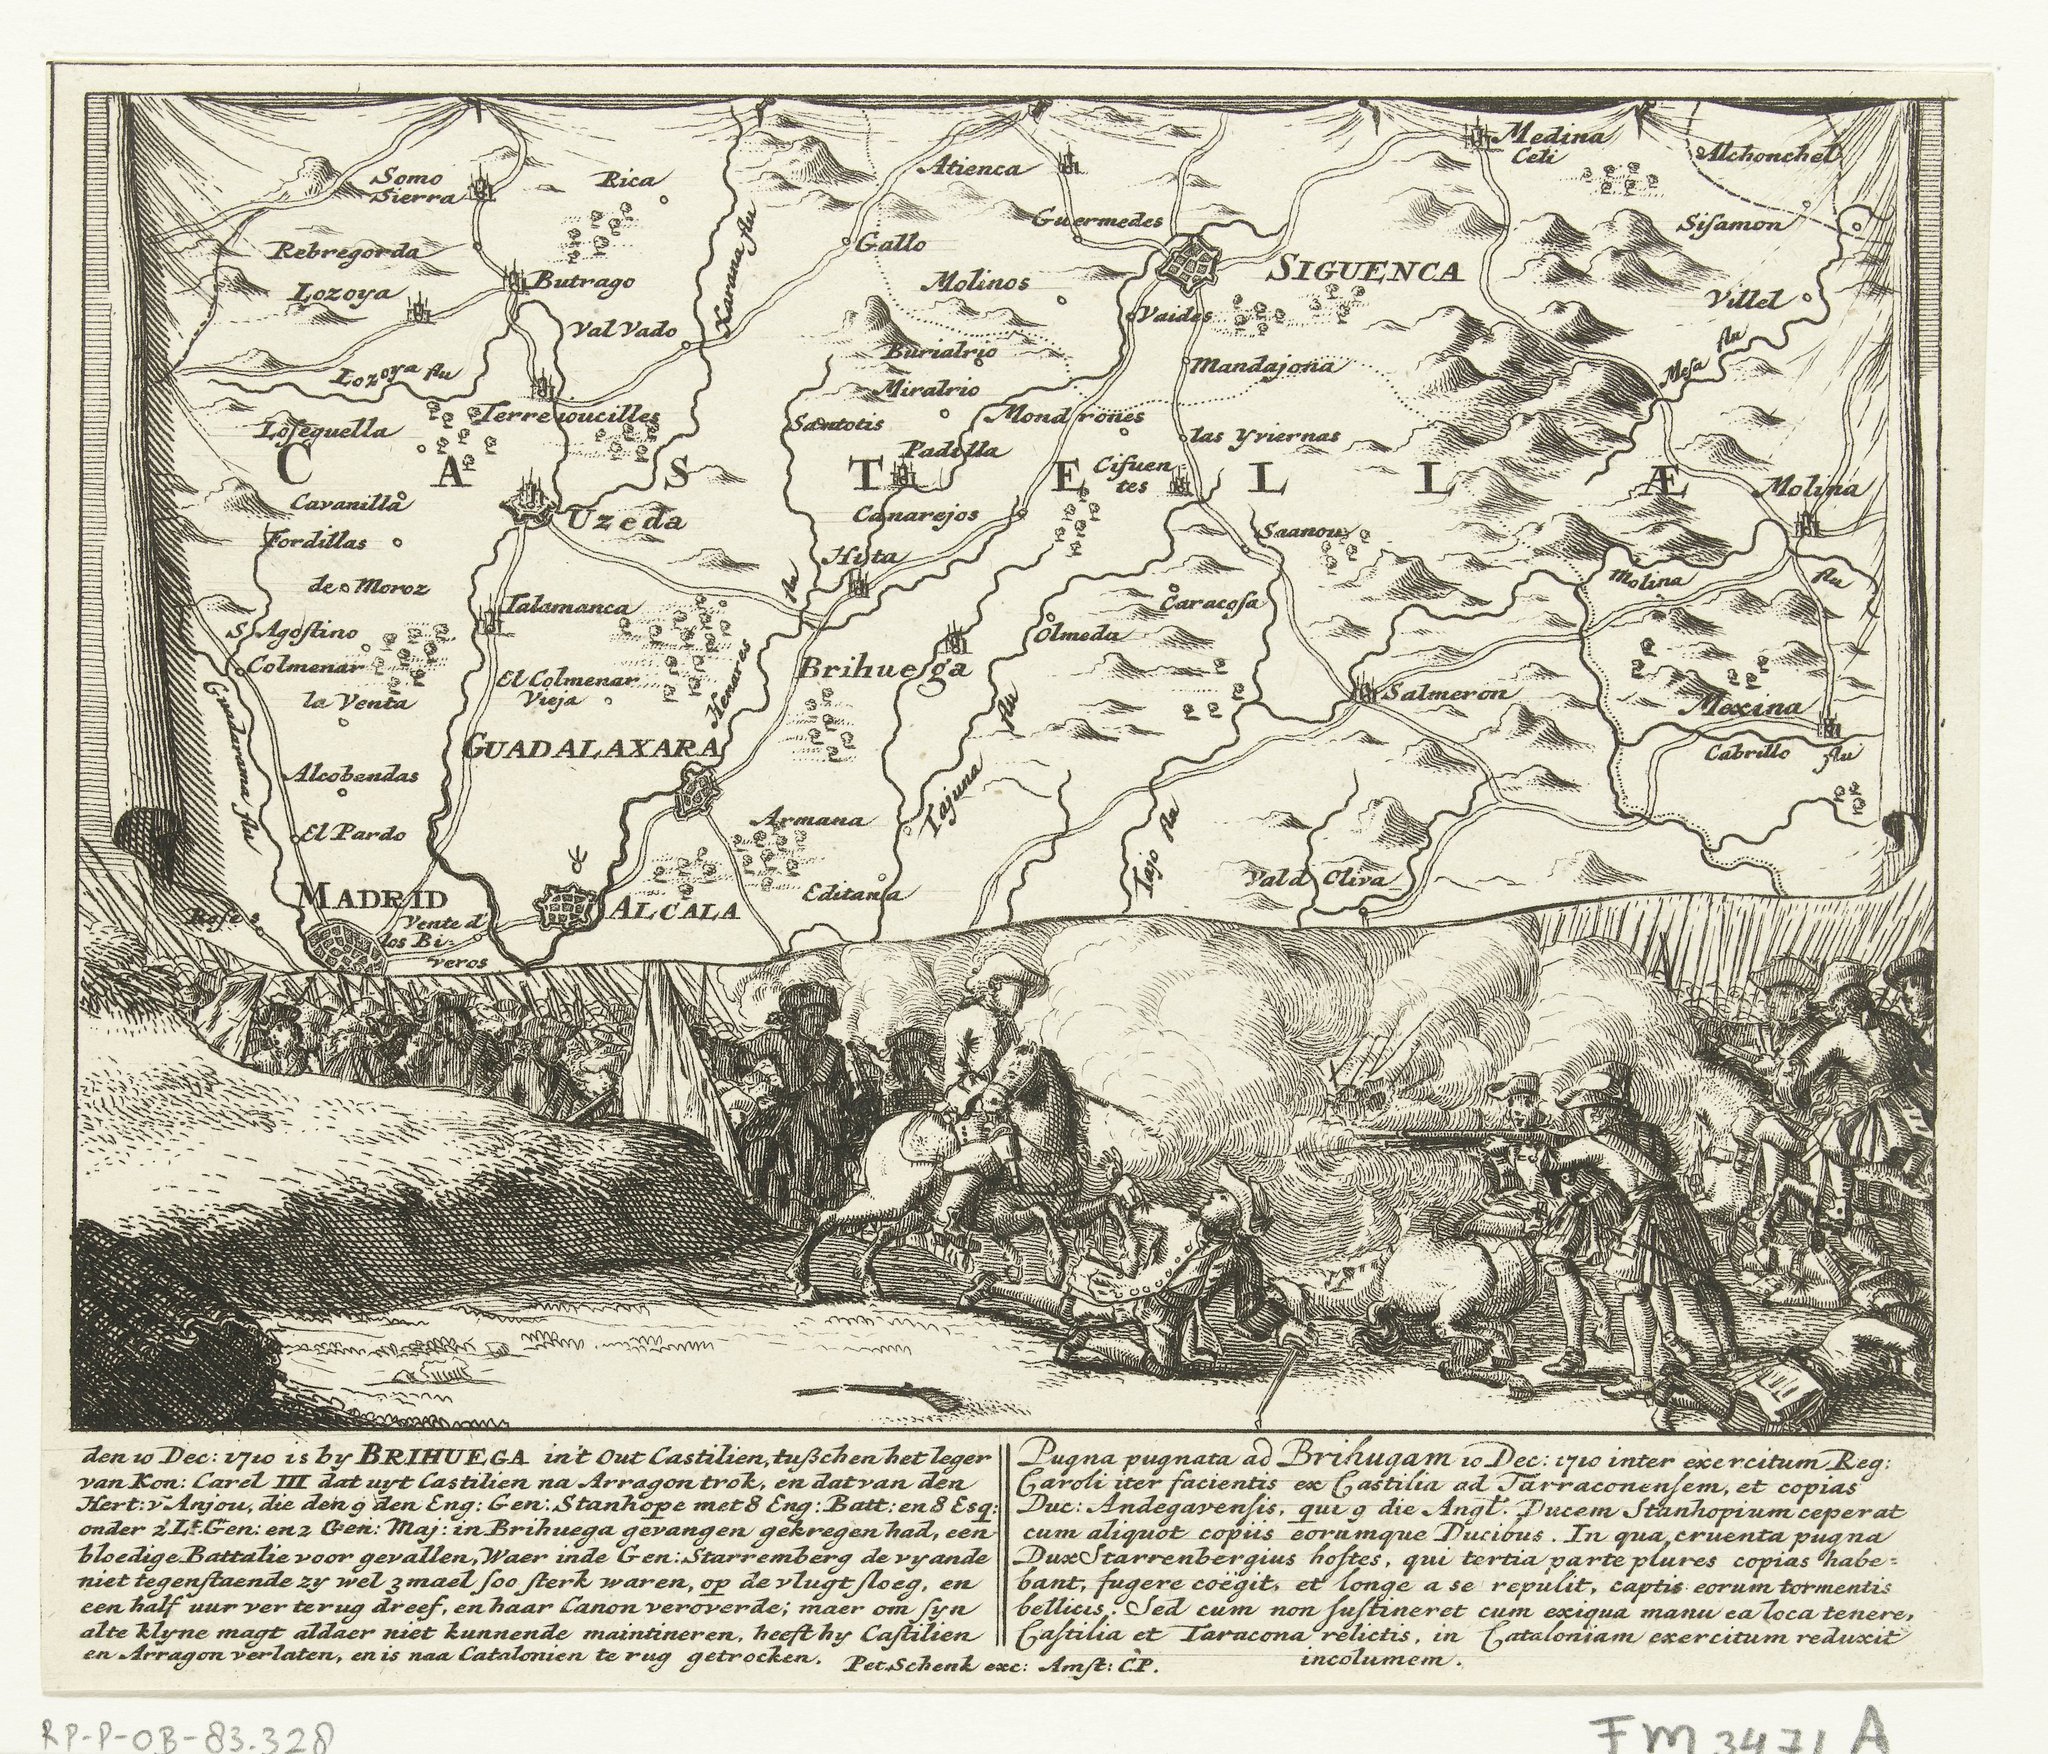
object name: print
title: den 9 Nov. 1710 heeft sig de Stad Aire (...) met accoort over gegeven (...)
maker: pieter schenk (i)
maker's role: print maker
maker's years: 1660-1711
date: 1710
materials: paper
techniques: etching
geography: amsterdam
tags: maps of separate countries or regions, battle (+ land forces)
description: Kaart en voorstelling van de slag bij Brihuega in Castilië waar de Fransen door de Geallieerden werden verslagen, 10 december 1710. Met onderschriften in het Nederlands en Latijn. Fragment van een grote plaat met negen voorstellingen van gebeurtenissen uit het jaar 1710 van de Spaanse Successieoorlog.